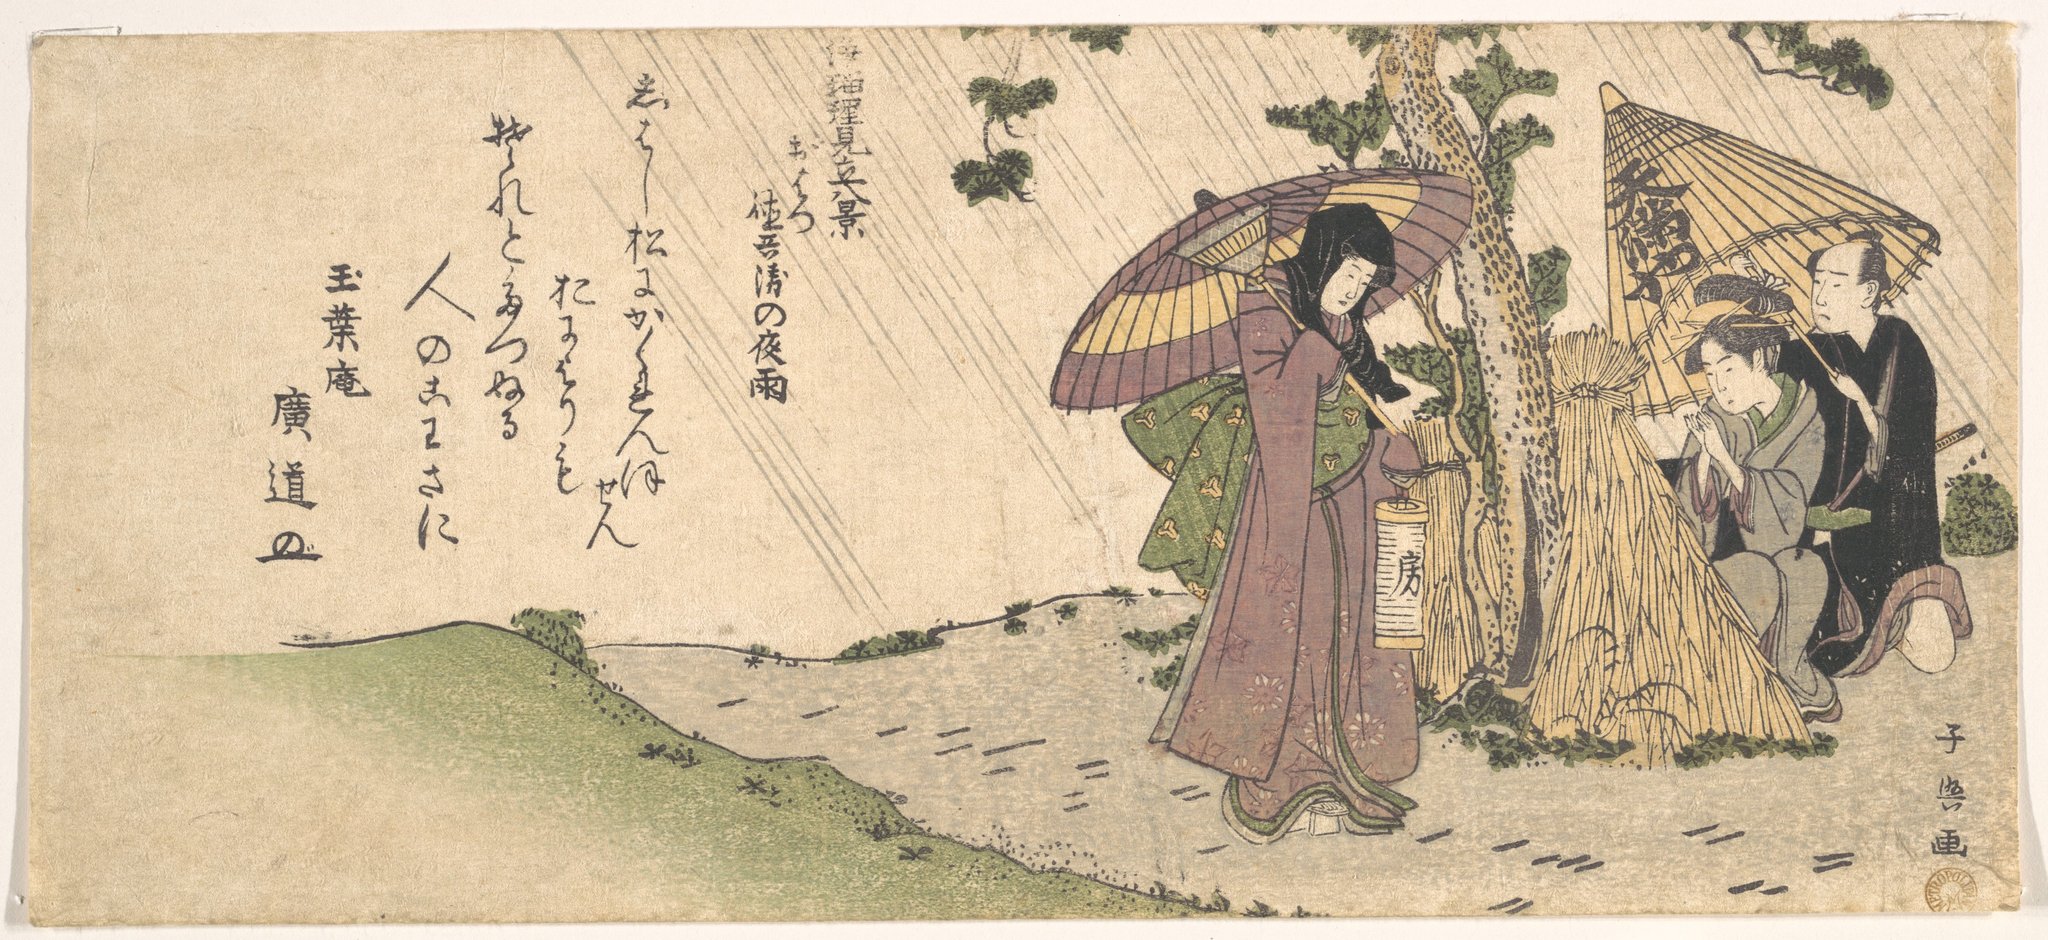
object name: print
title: Where is Tokubei?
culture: japanese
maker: momokawa shiko ii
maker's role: artist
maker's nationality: japanese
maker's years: 1797-1810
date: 1800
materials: ink, paper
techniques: woodblock print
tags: men,women,trees